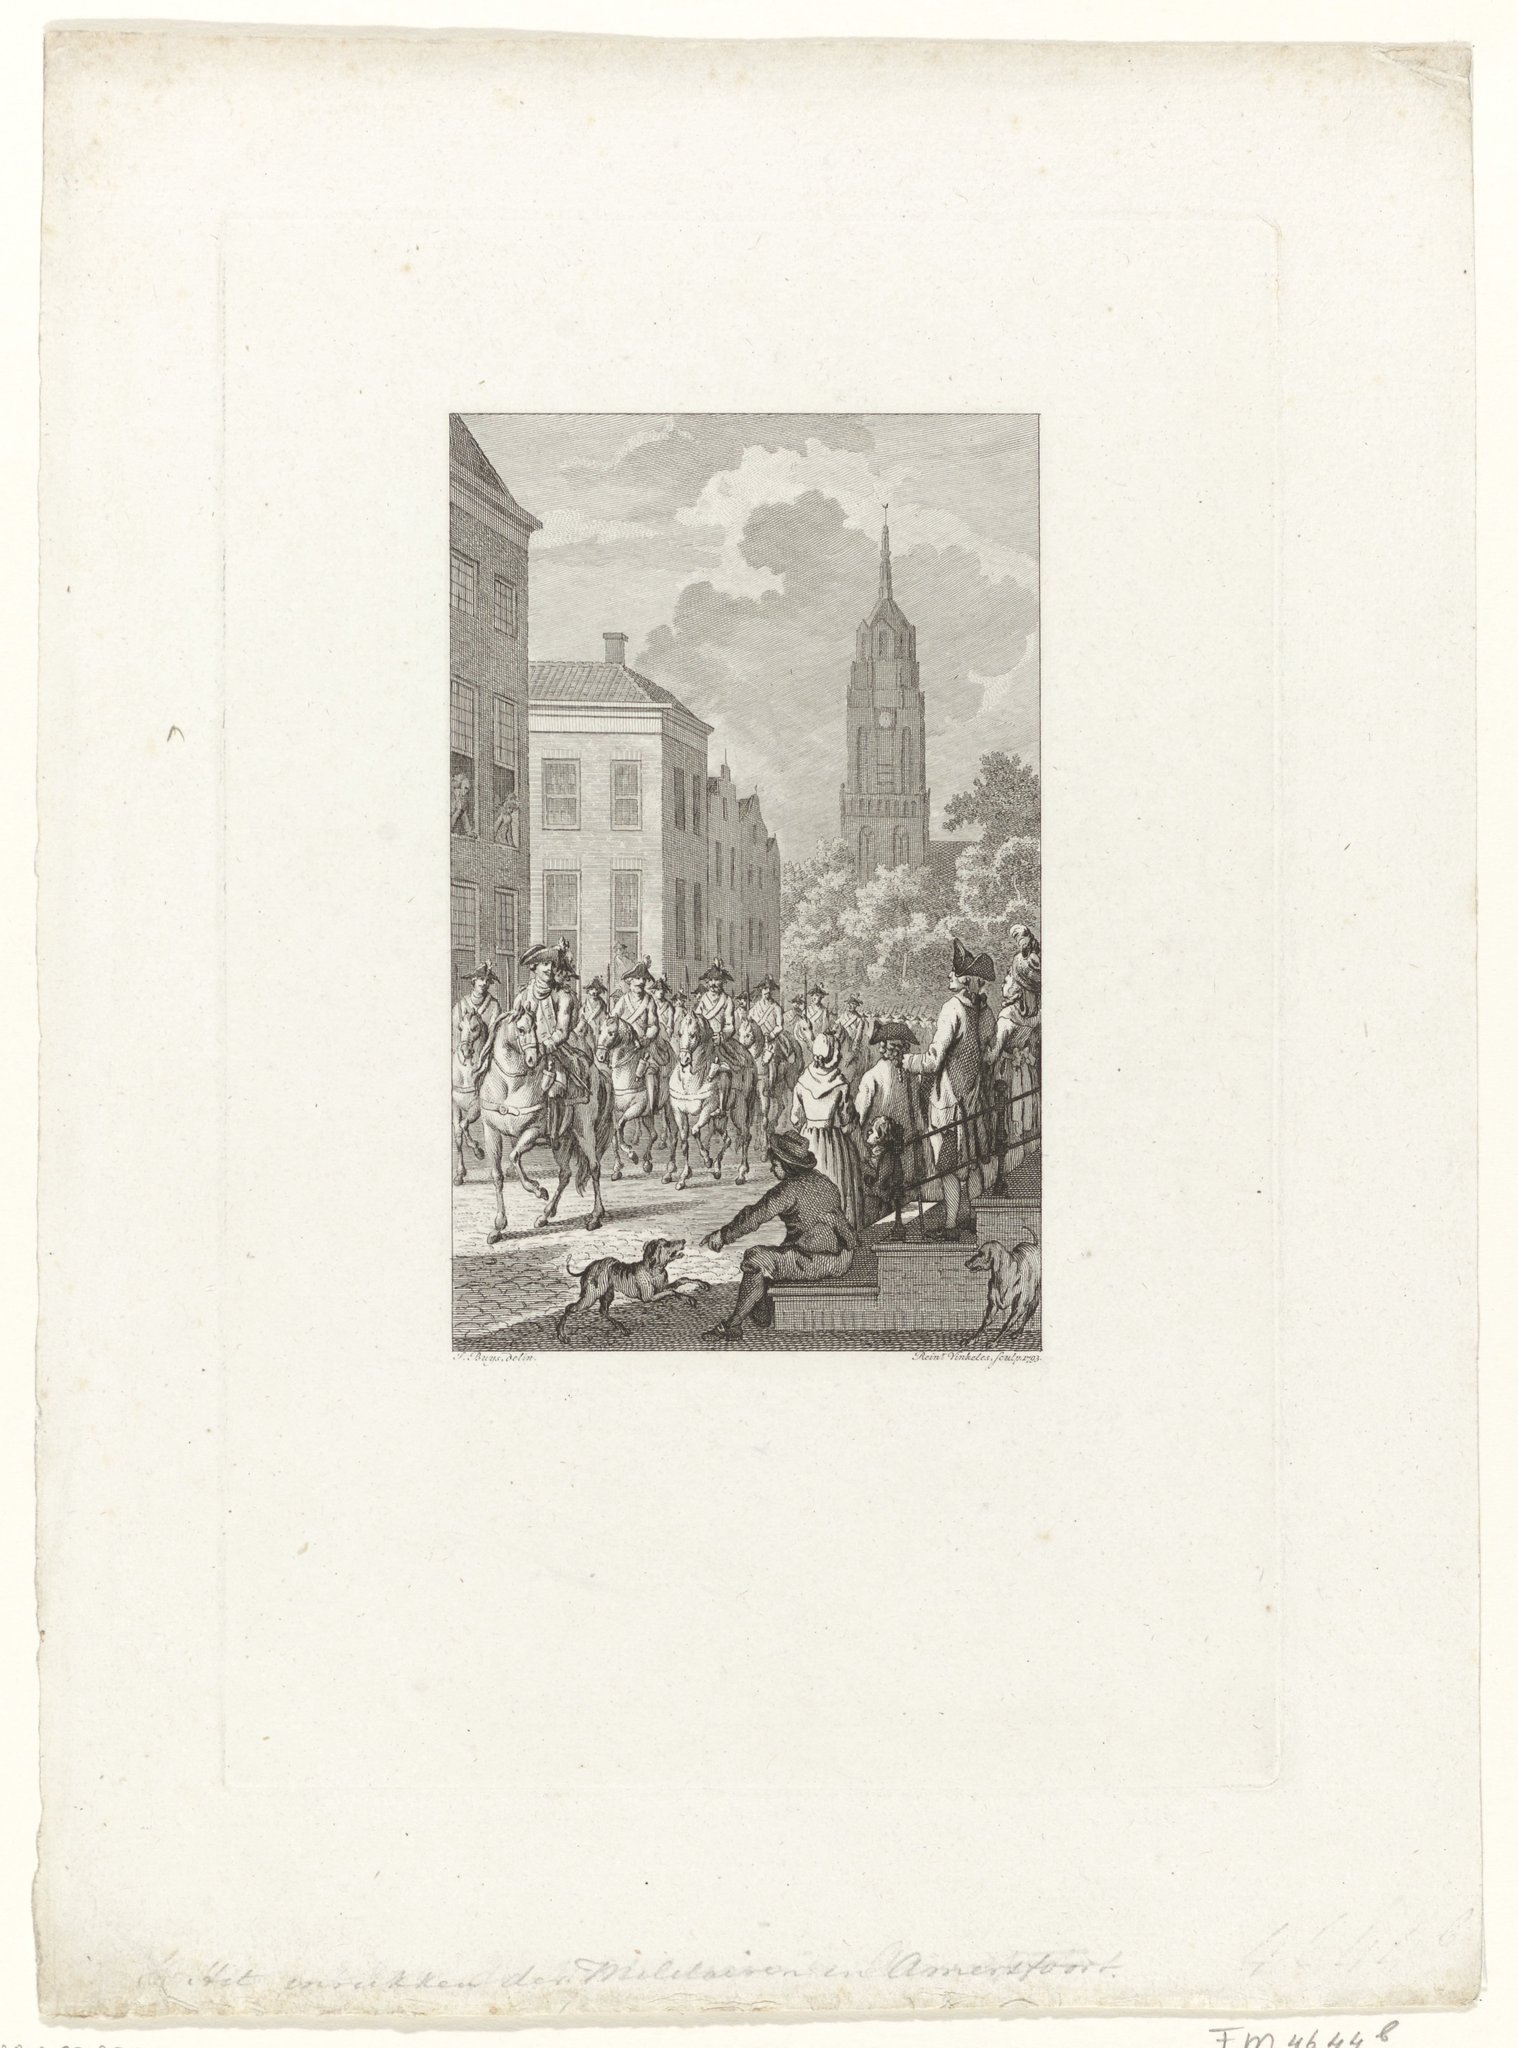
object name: print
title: Inrukken van militairen in Amersfoort, 1785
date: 1793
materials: paper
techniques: etching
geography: northern netherlands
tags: patriots (1780-1795)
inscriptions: collector's mark: Lugt 2228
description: Gebruikt als illustratie in: P.A. Loosjes. Vaderlandsche historie, vervattende de geschiedenissen, der Vereenigde Nederlanden (...). Ten onmiddelyken vervolge van Wagenaar's Vaderlandsche historie. Amsterdam: Johannes Allart, dl. 11.